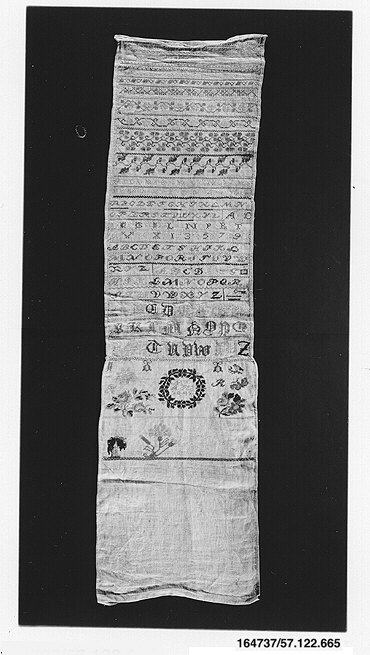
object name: sampler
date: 1841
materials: linen, silk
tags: flowers,wreaths